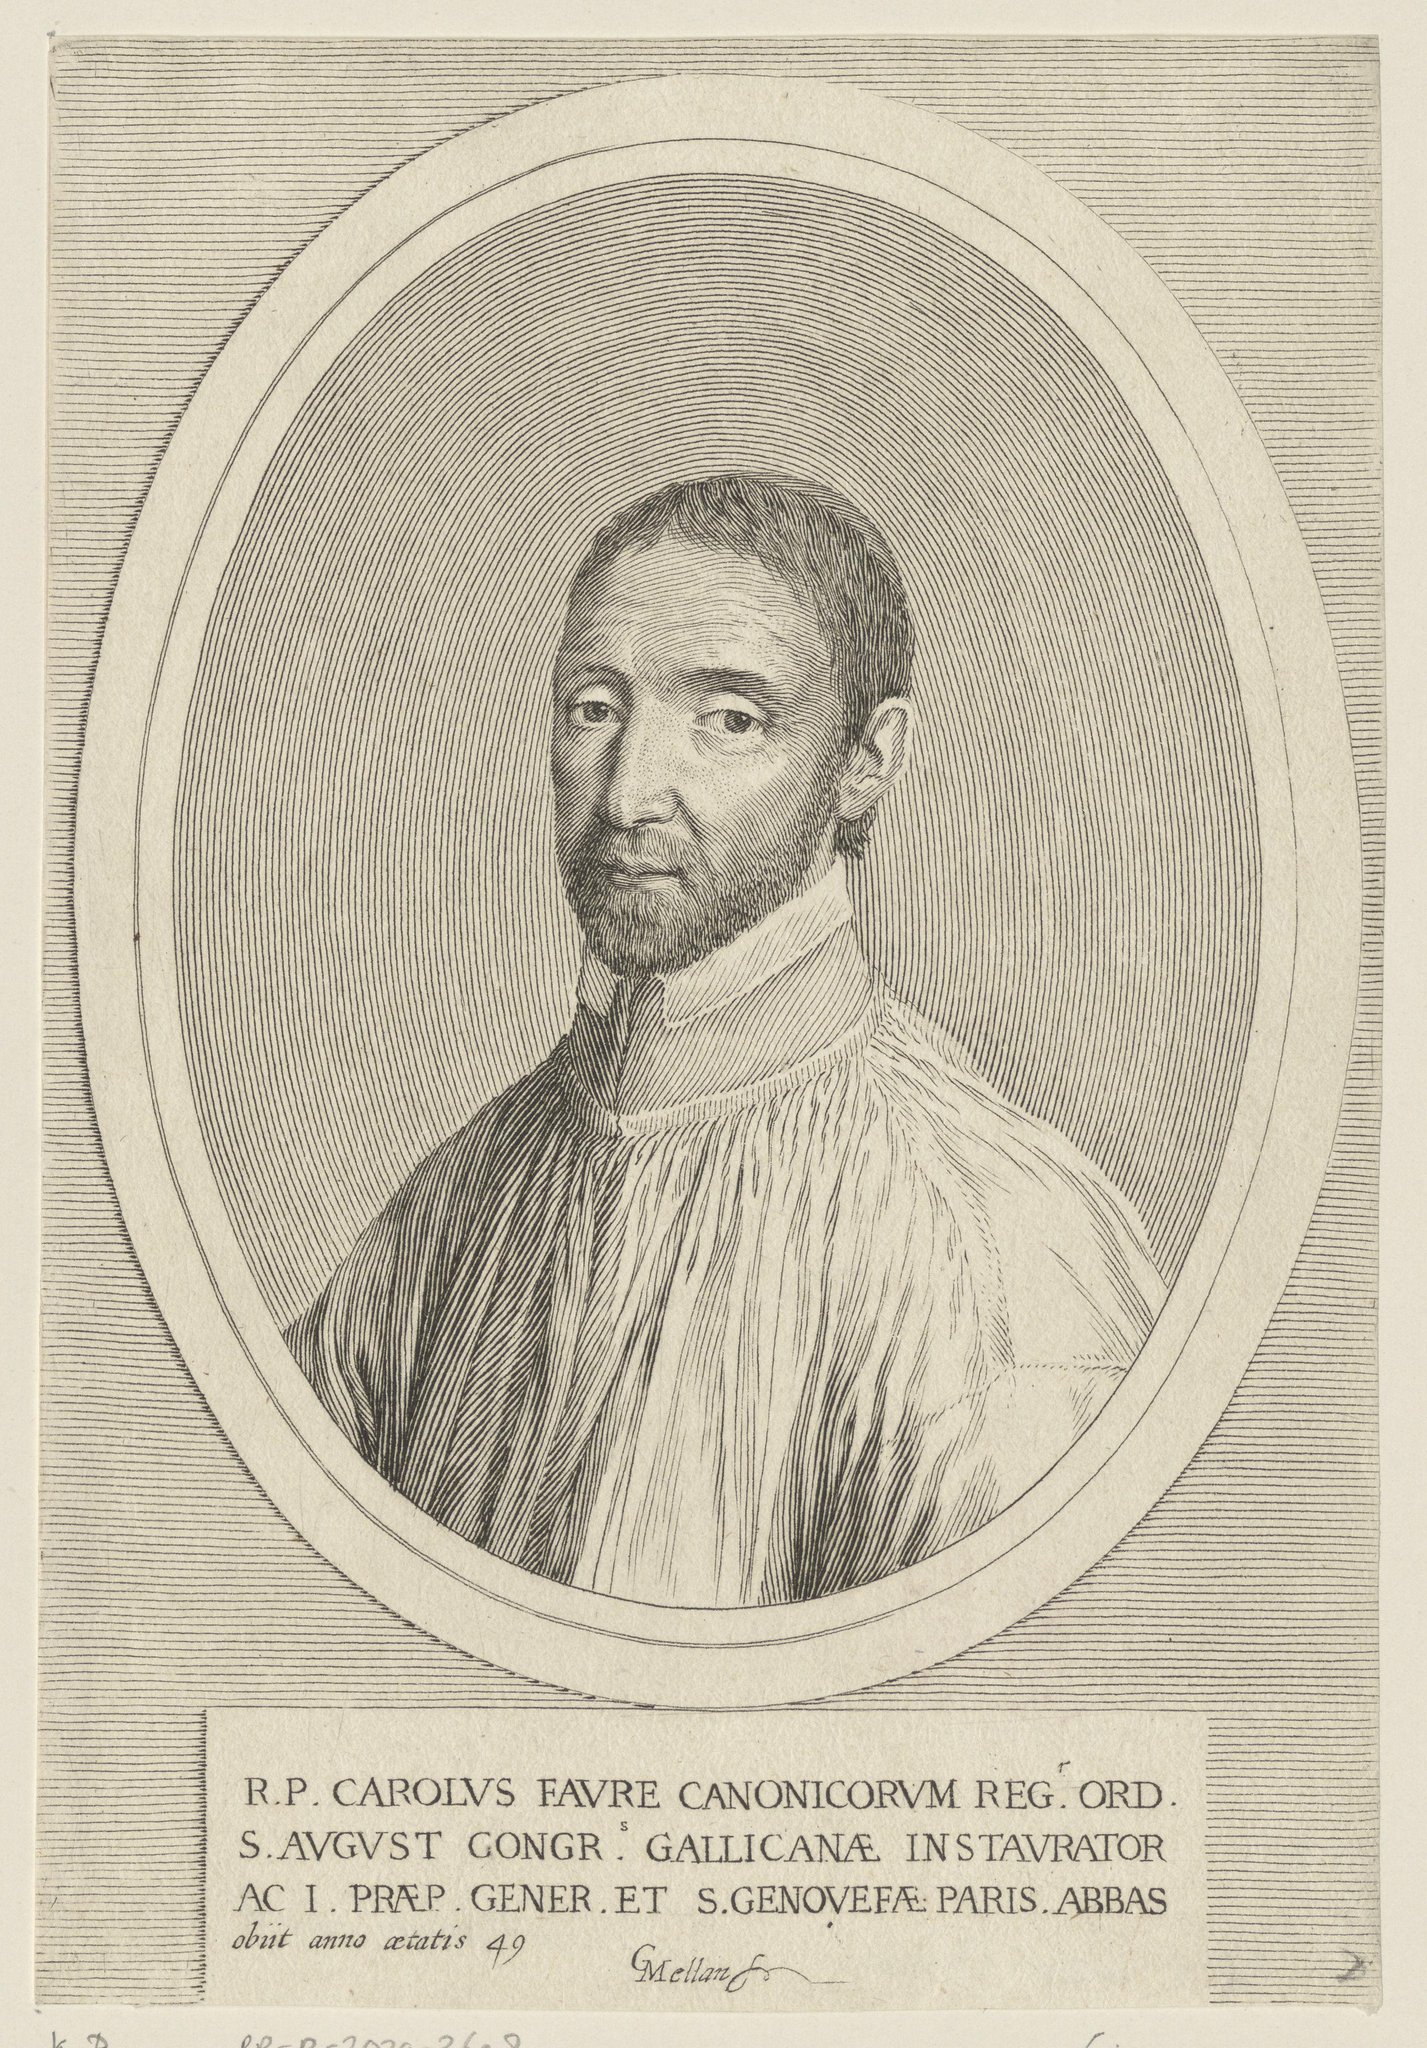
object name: print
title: Portret van Charles Faure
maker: claude mellan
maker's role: draughtsman, print maker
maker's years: 1598-1688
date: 1644-1688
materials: paper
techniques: engraving, etching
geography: france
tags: clergyman, charles faure, historical persons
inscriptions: collector's mark: Lugt 240